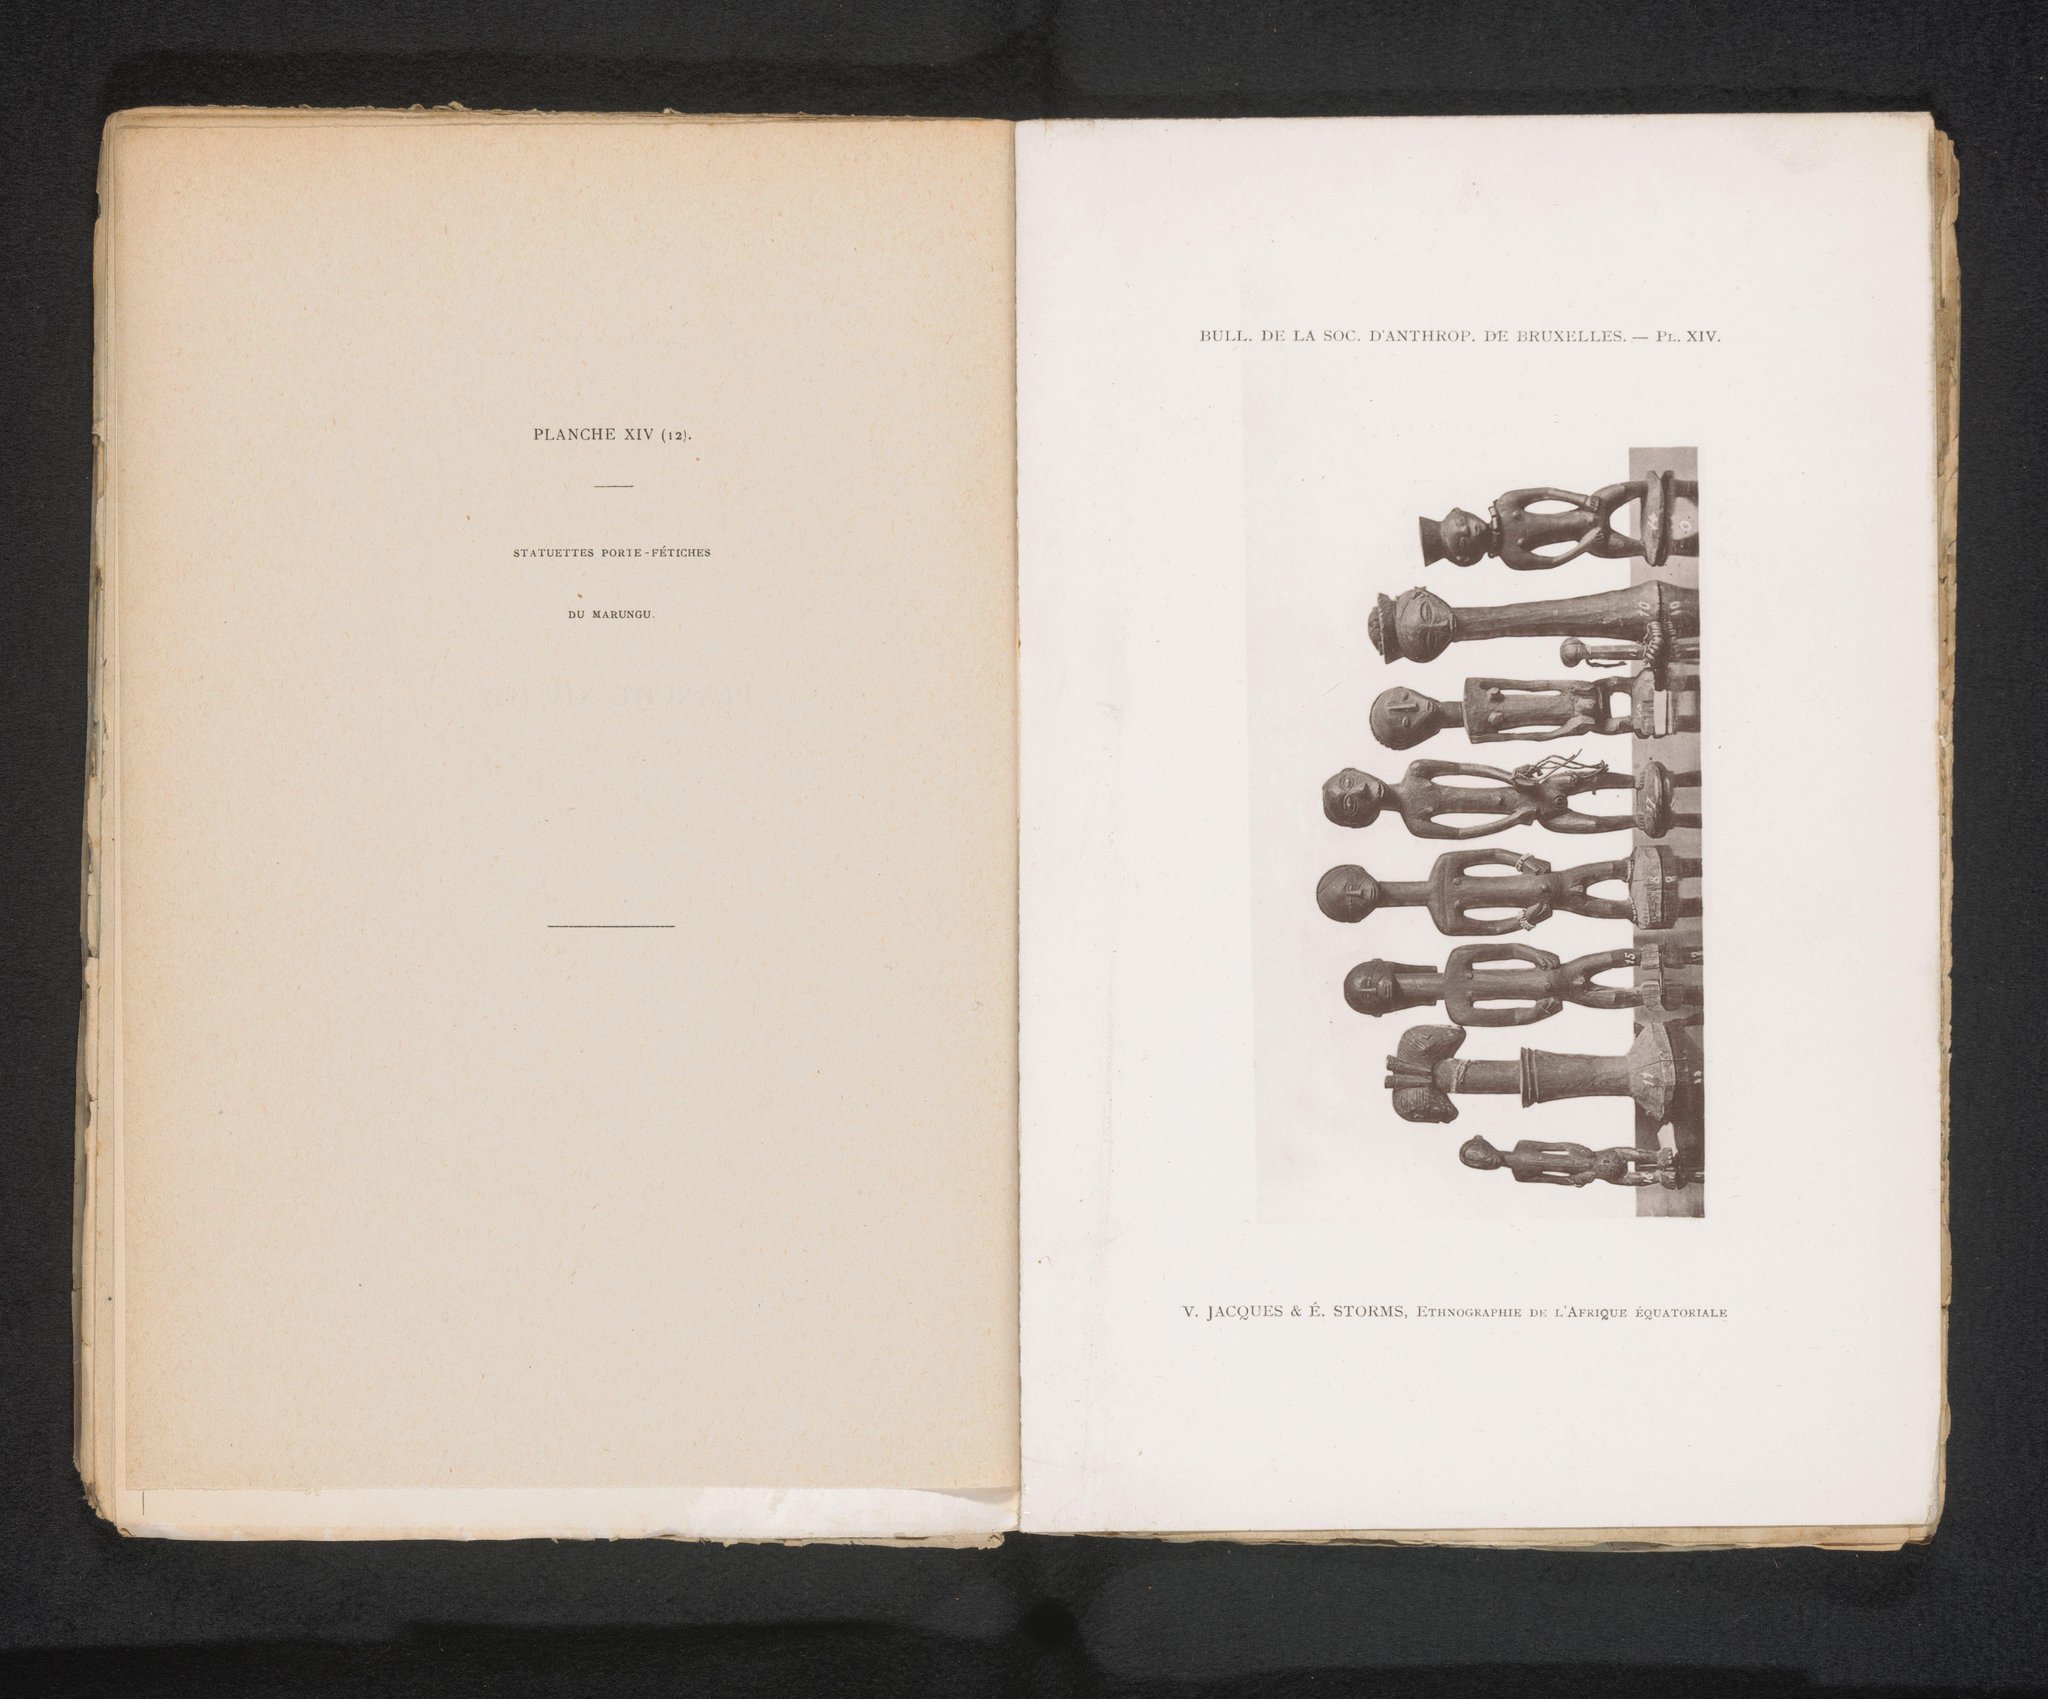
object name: page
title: Sculpturen uit Marungu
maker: Anonymous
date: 1882-1887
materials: paper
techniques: photograph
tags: sculpture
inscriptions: inscription: ‘Bull. de la Soc. D'Anthrop. de Bruxelles - Pl. XIV./ V. Jacques & É. Storms, Ethnographie de l'Afrique Équatoriale’